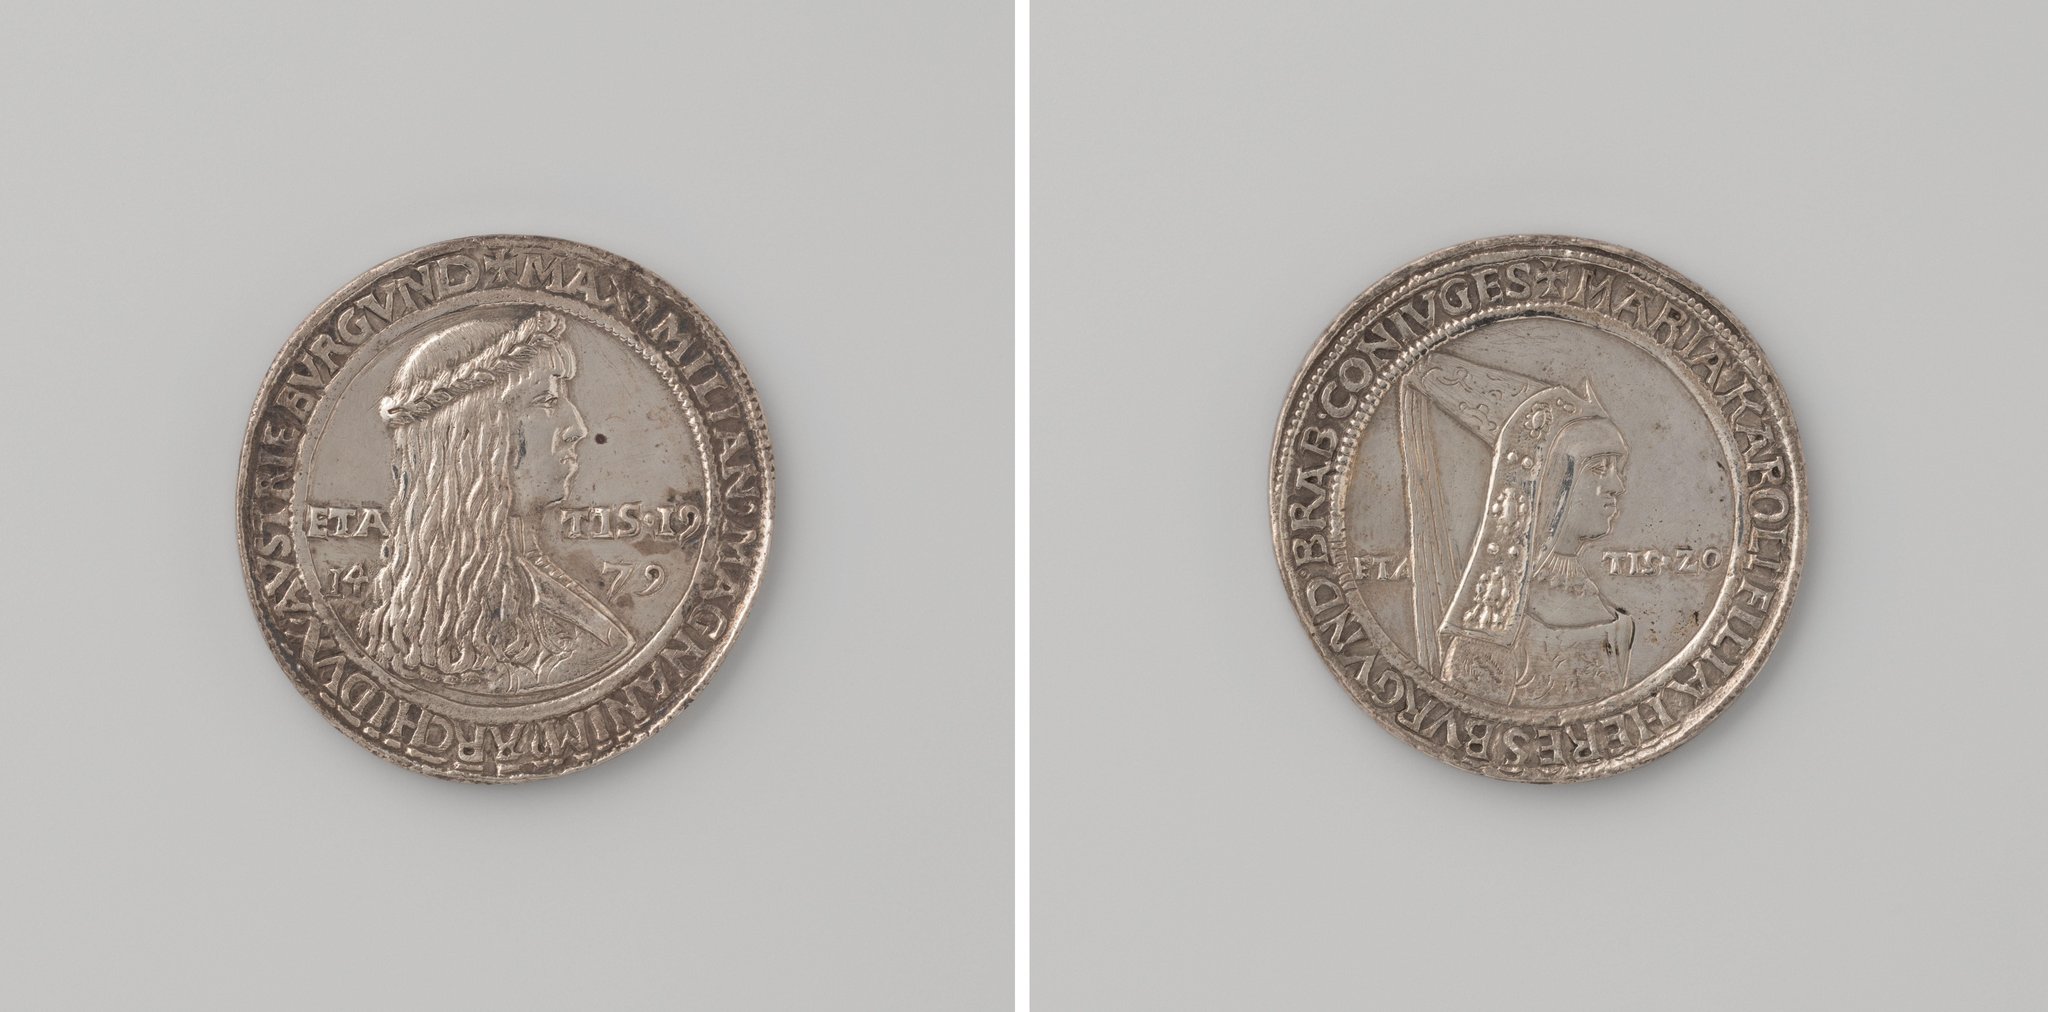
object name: history medal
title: Maximiliaan, aartshertog van Oostenrijk en Maria, hertogin van Bourgondie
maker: ulrich gebhart (utz)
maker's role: die cutter, mintmaster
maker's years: 1479-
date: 1506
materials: silver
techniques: striking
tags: brussels, bruges, maria (hertogin van bourgondië), maximilian i (holy roman emperor)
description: Zilveren penning. Voorzijde: borststuk man met lauwerkrans tussen opschrift, binnen omschrift. Keerzijde: borststuk vrouw met hoge muts tussen opschrift, binnen omschrift